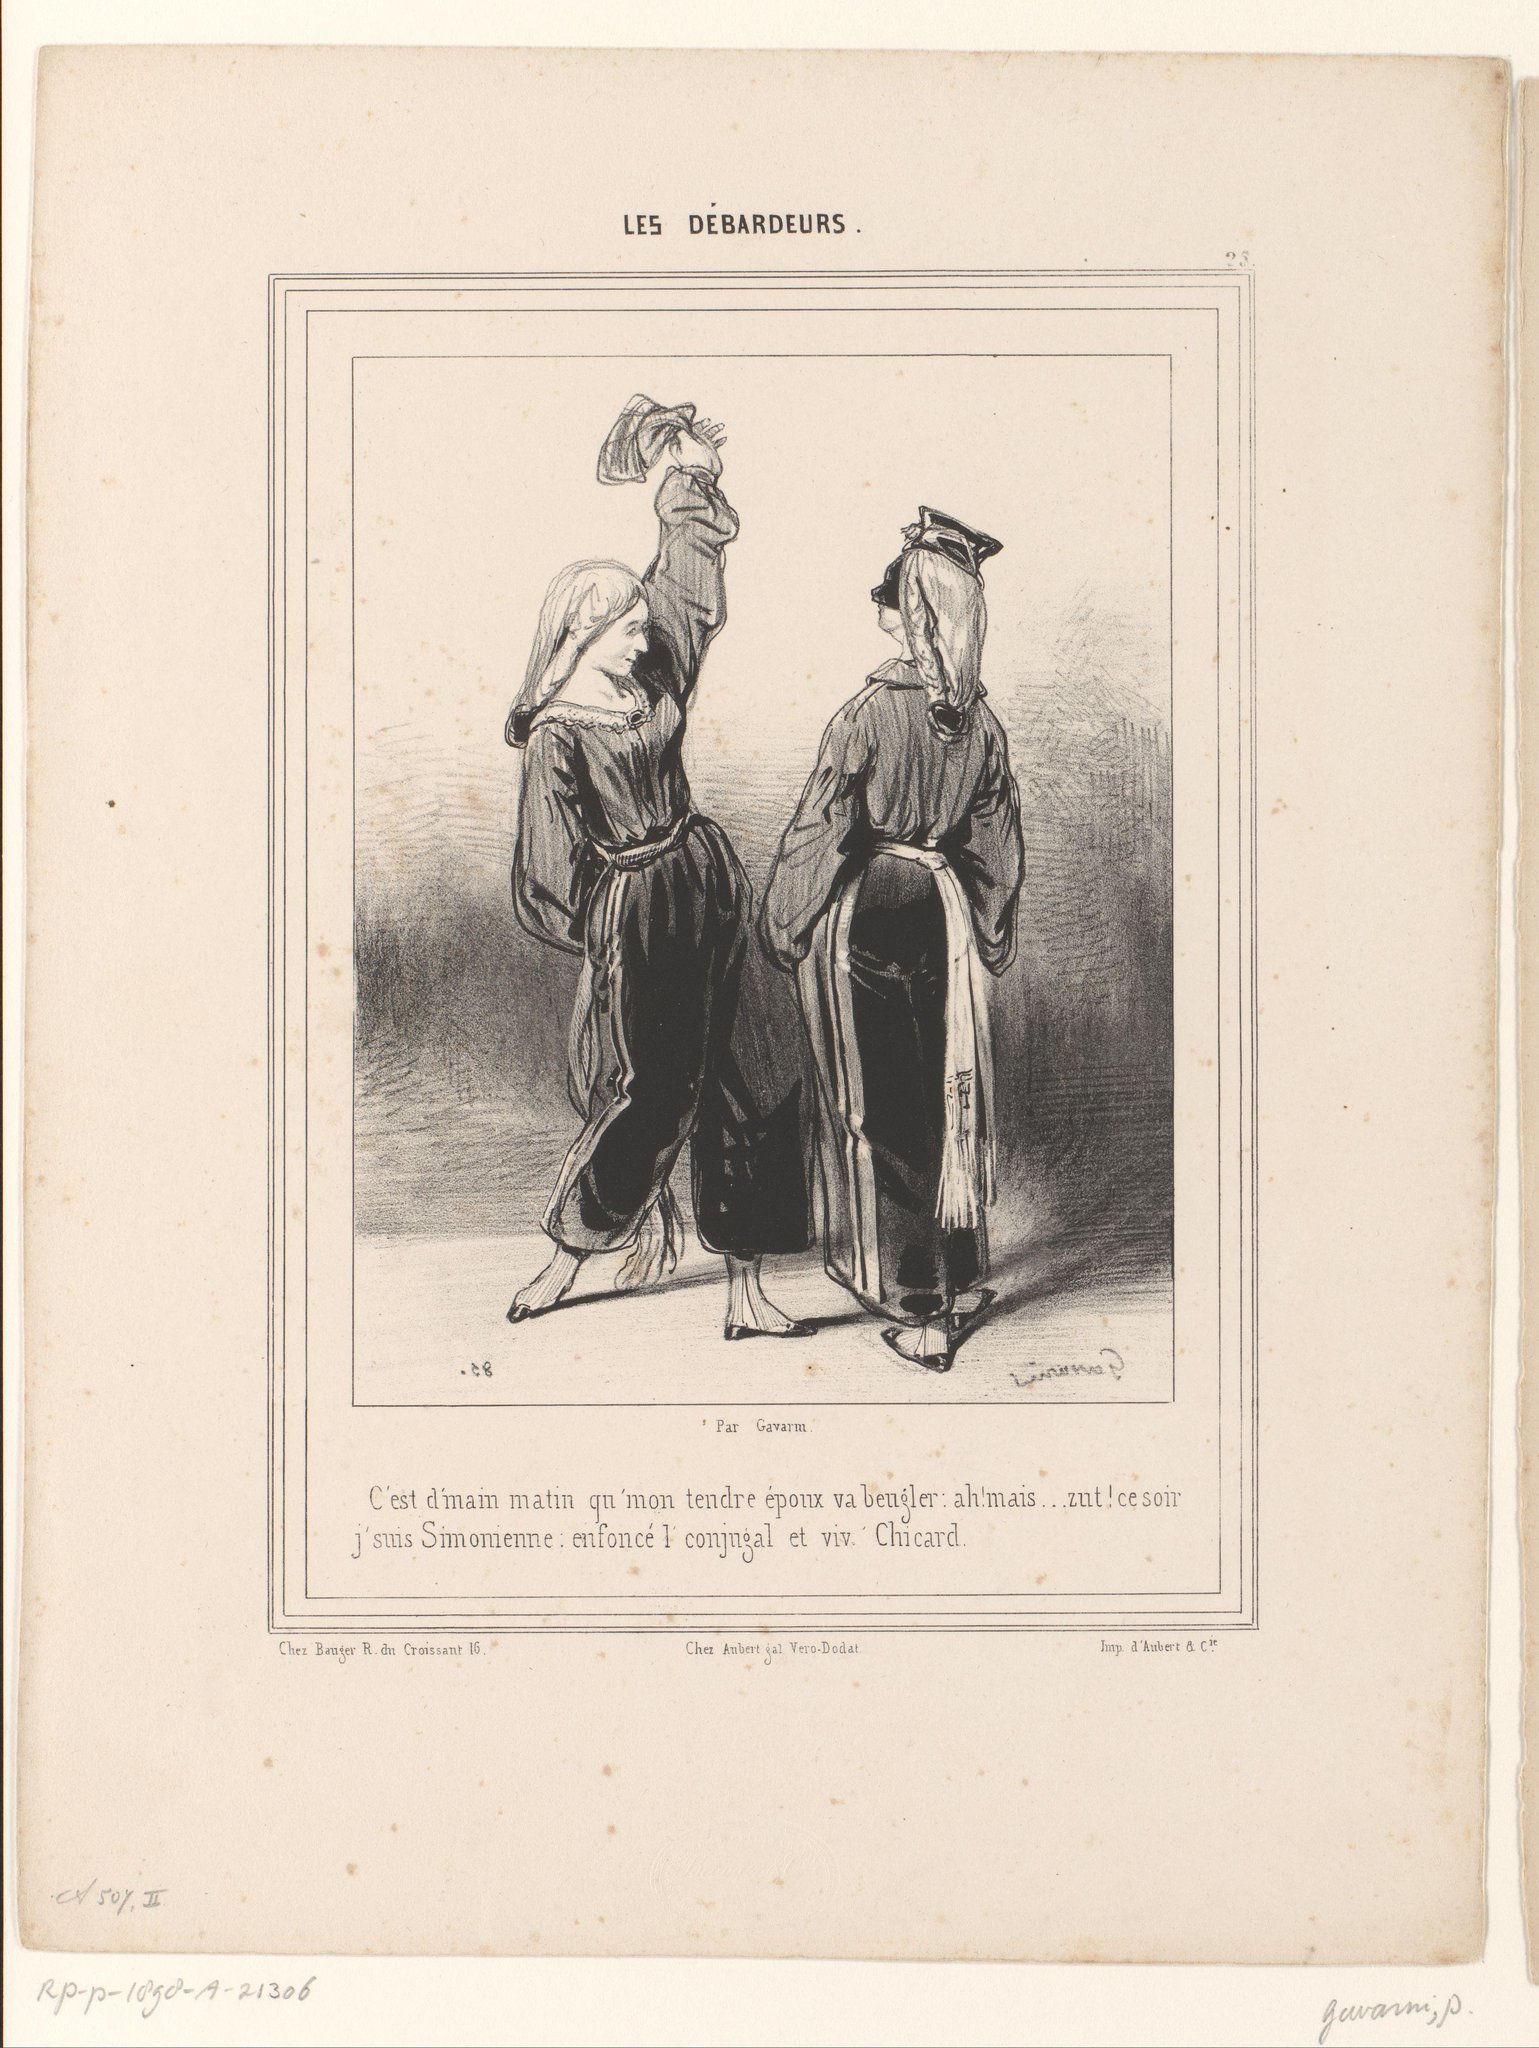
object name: print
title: Les débardeurs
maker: paul gavarni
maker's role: draughtsman, print maker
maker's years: 1804-1866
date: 1840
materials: paper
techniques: lithograph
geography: paris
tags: mask, fashion, clothing, adult woman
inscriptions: collector's mark: Lugt 964, check stamp: Lugt 3855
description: Prent gebruikt voor: Le Charivari, 3 augustus 1840.